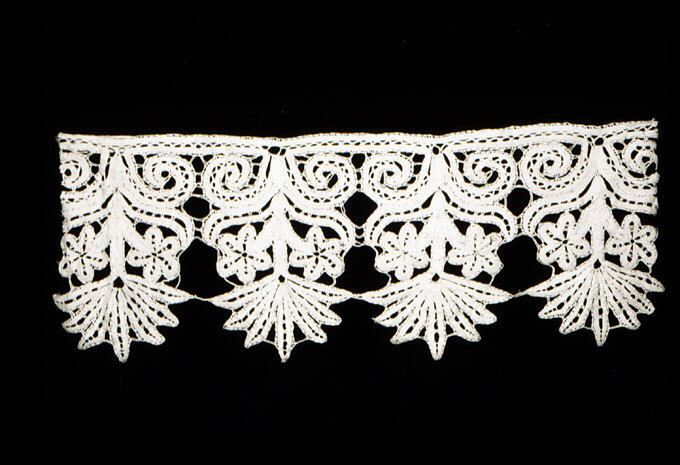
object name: fragment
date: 1601-1700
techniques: lace